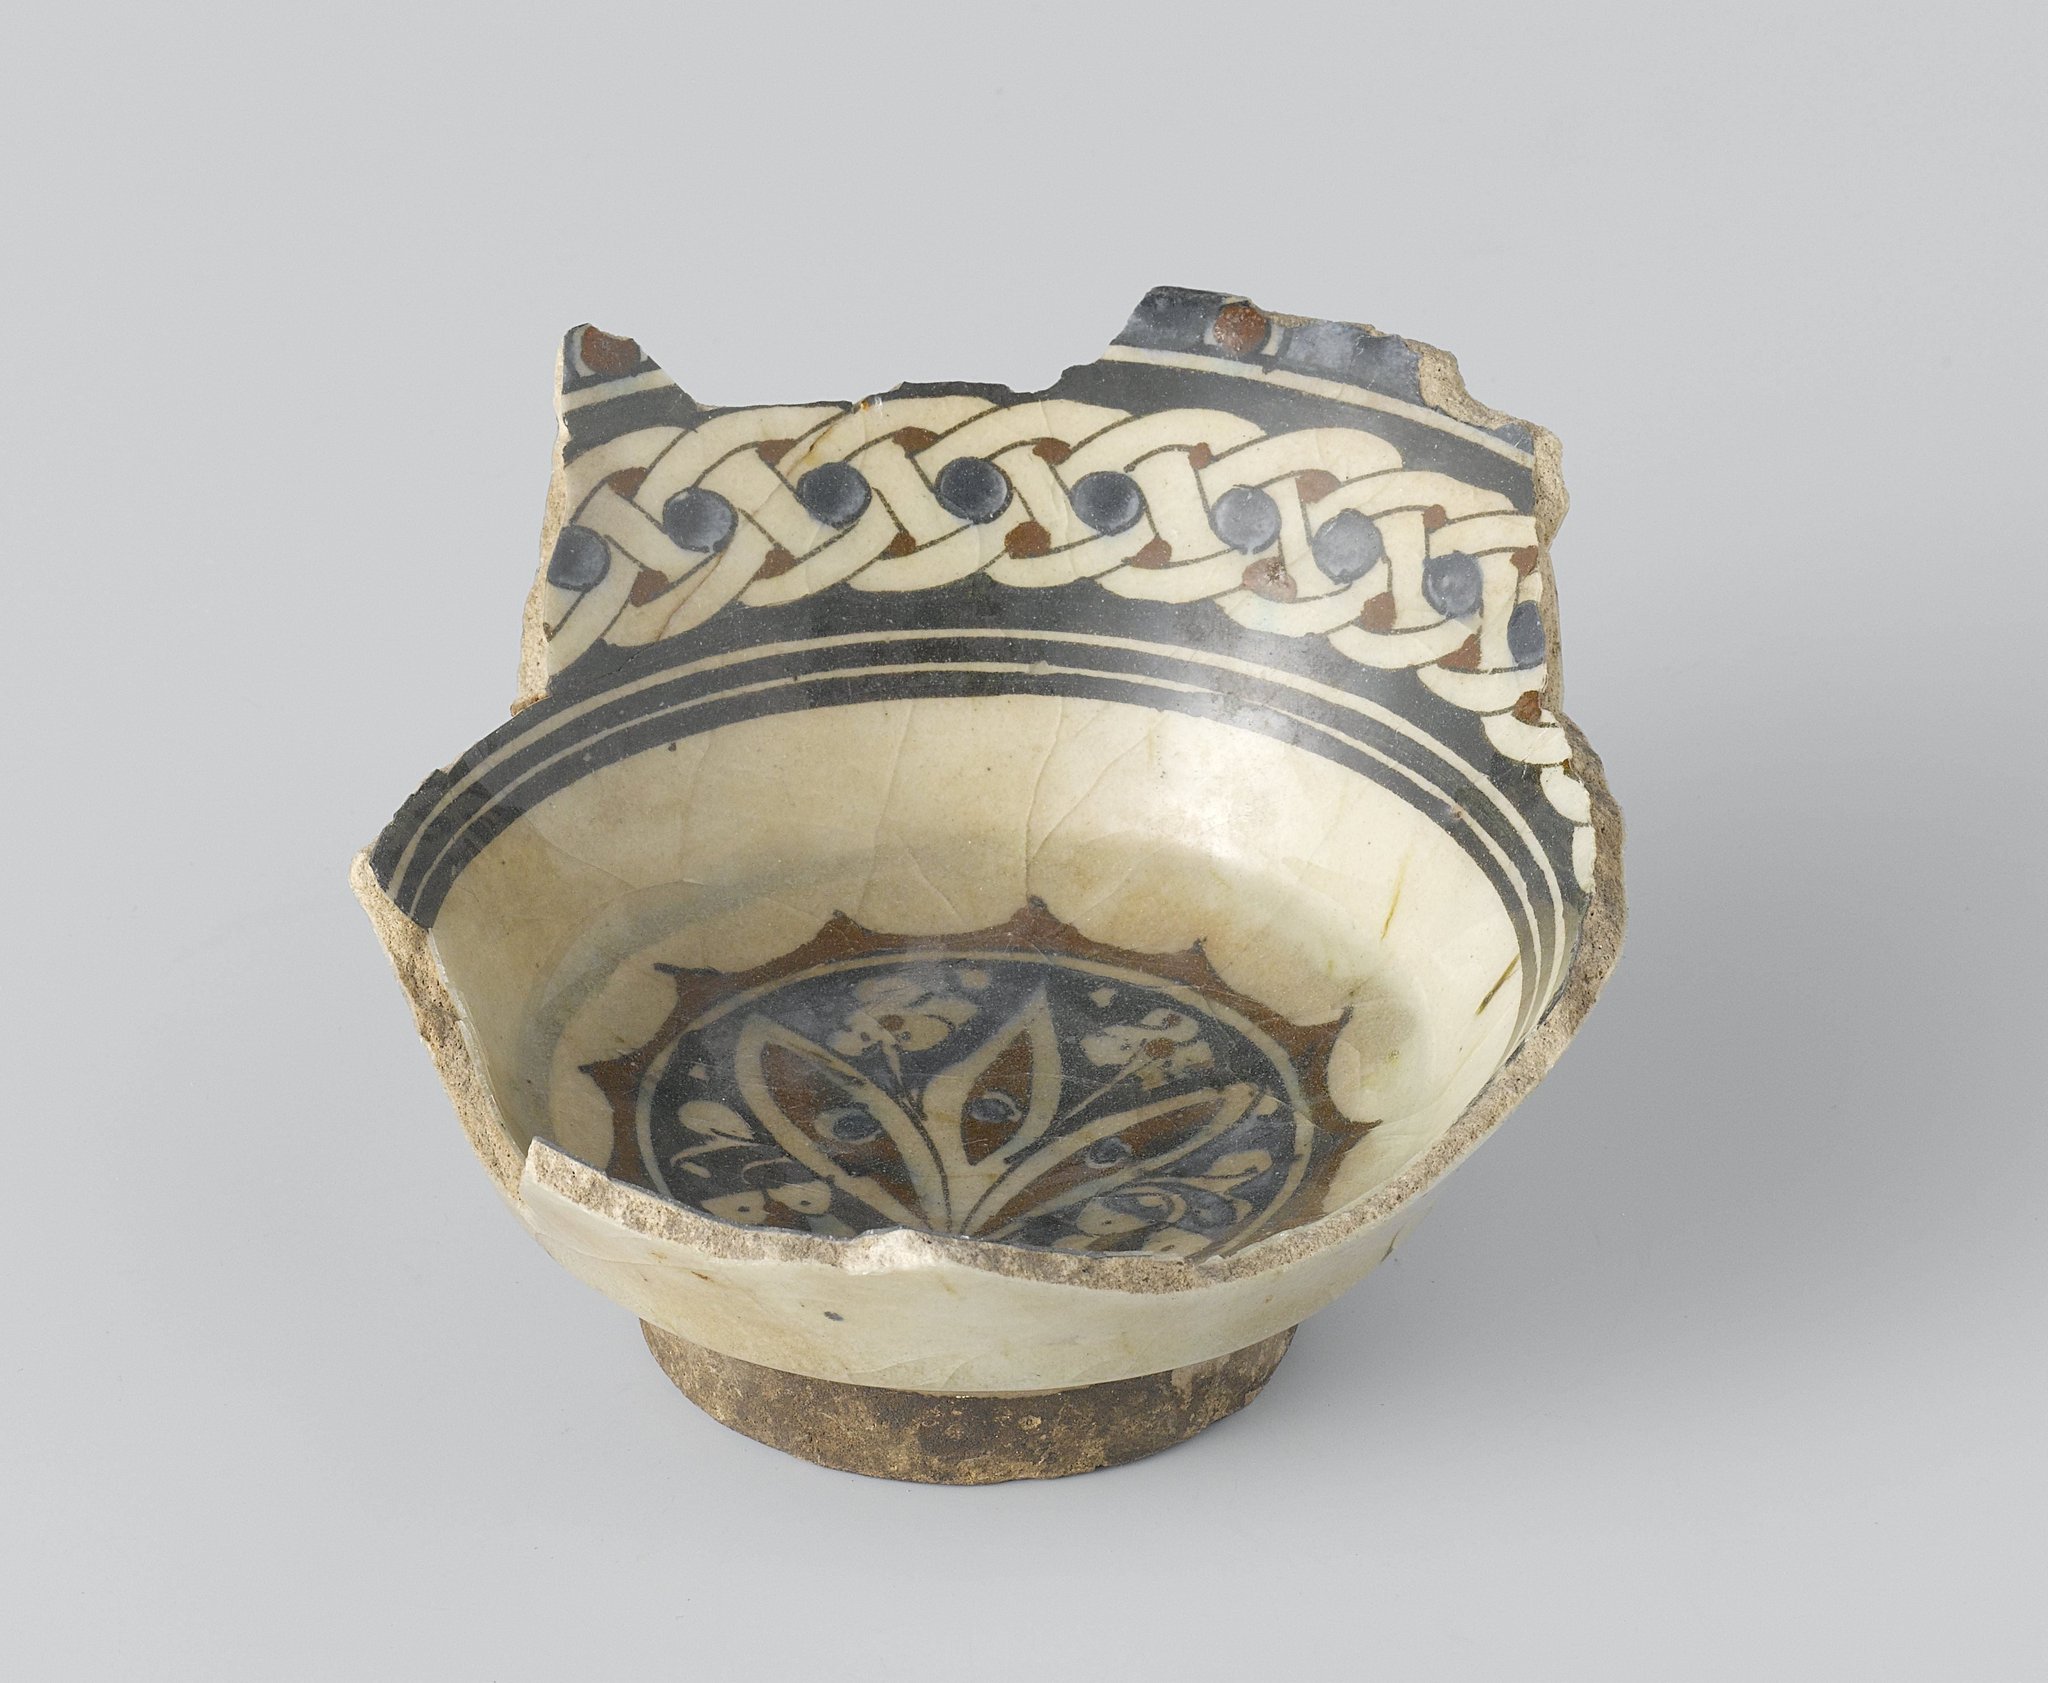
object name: bowl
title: Fragment of a bowl with a flowering plant in a medallion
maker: Anonymous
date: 1150-1224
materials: earthenware, glaze, paint, quartz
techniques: firing, turning, vitrification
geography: syria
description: Fragment van een kom van kwarts-fritgoed. Grijsgele scherf op een witte engobe. Op de bodem een bloeiende plant in een medaillon in rood en blauw, met zwarte omtrekken zijn geschilderd. Op de binnenwand een band met vlechtwerk in dezelfde kleuren. Buiten een dessin van ovale in elkaar grijpende zwarte lijnen langs de blauwe rand. De voet is ongeglazuurd. Het fragment is gevonden te Cairo.